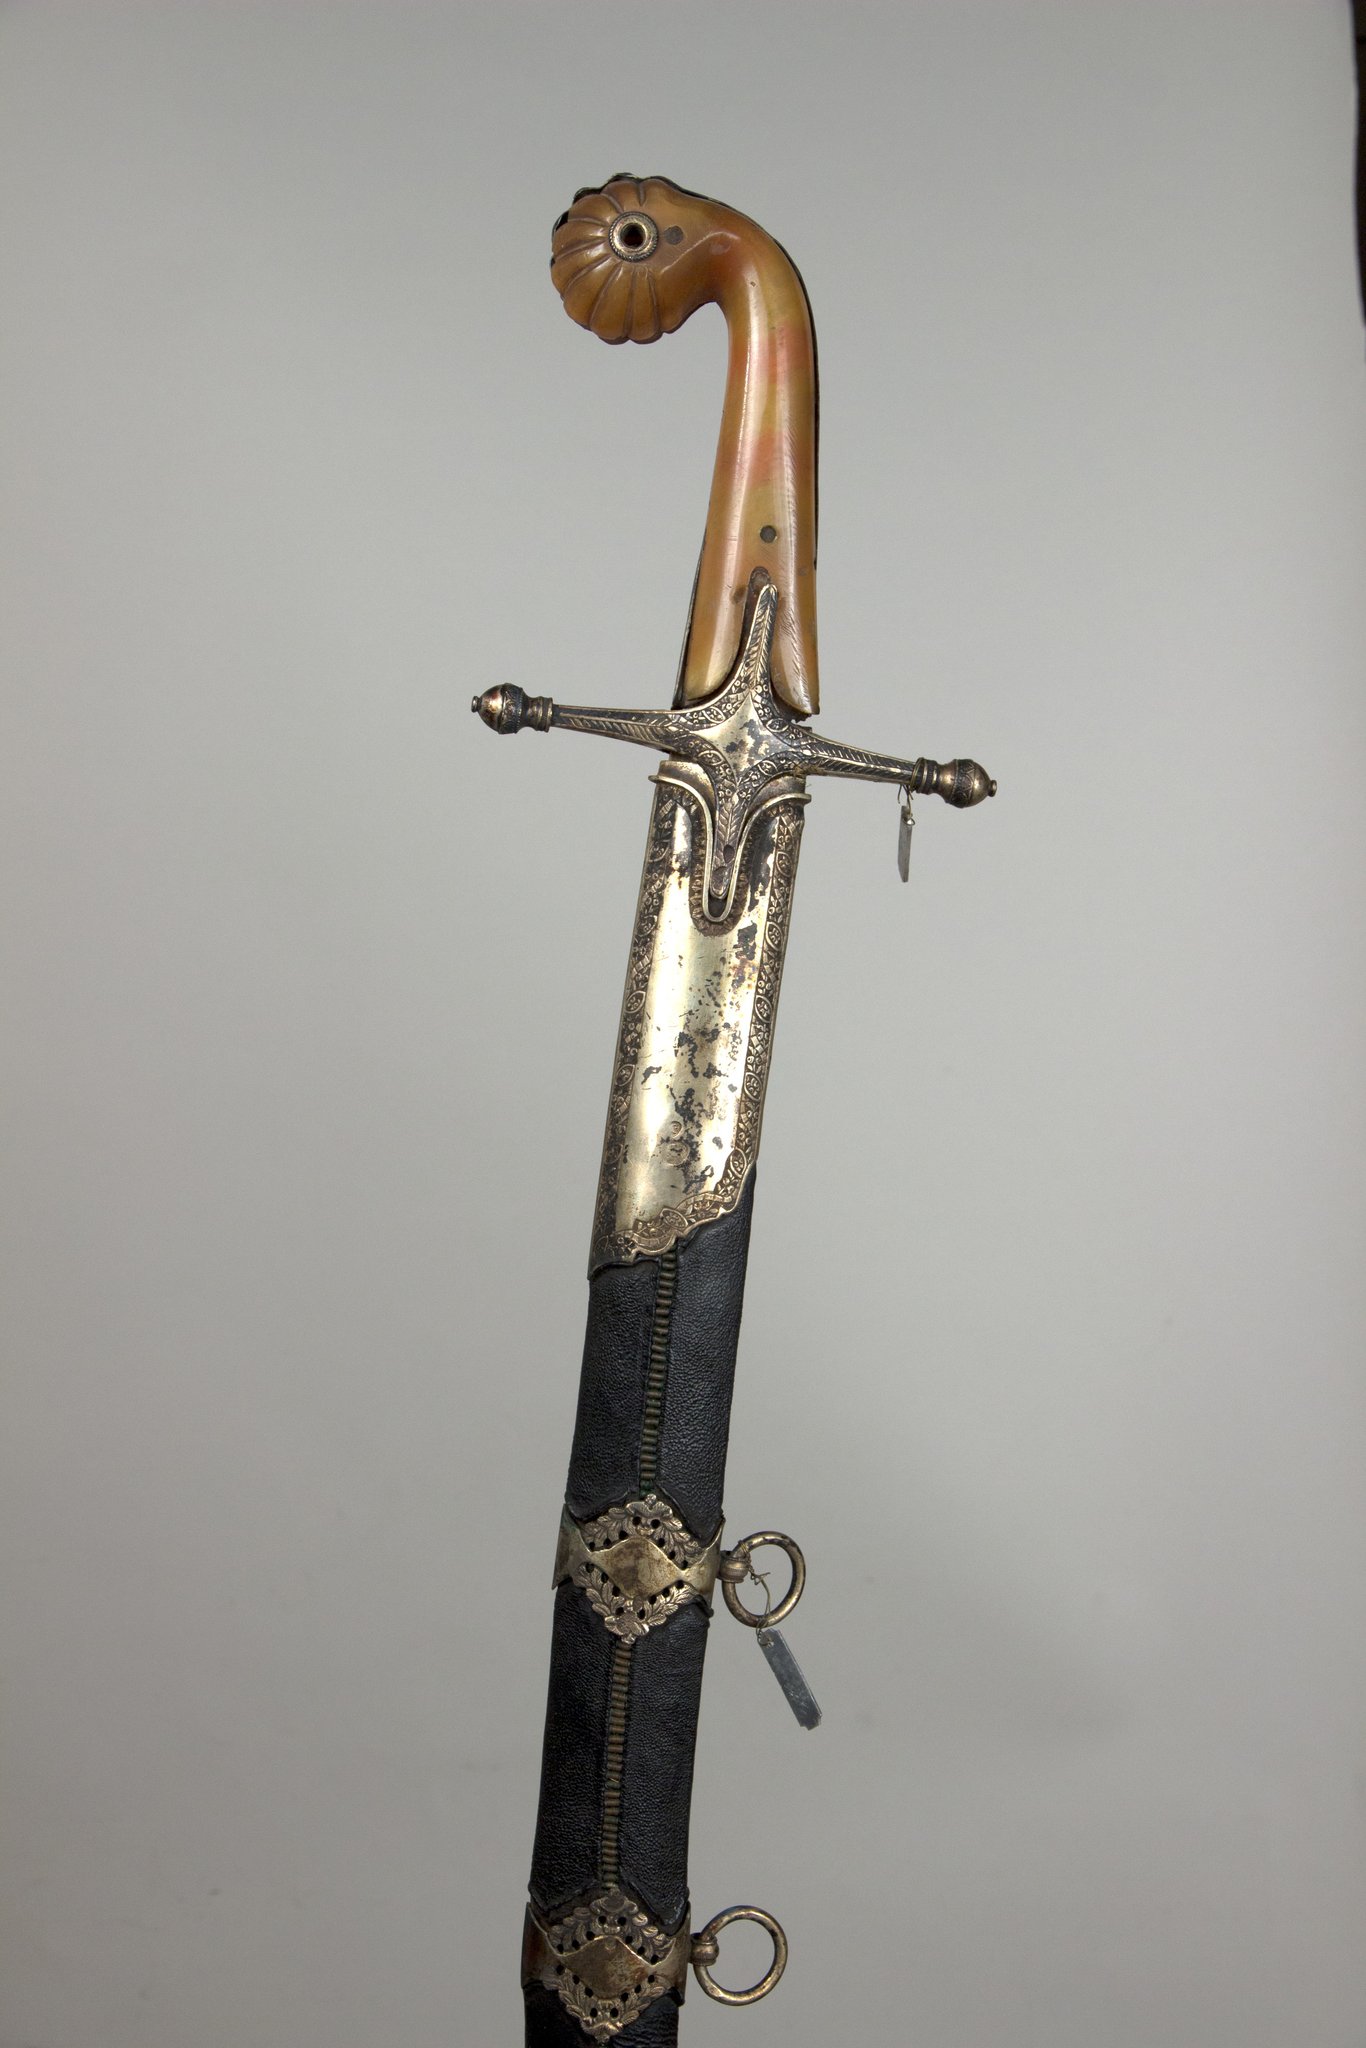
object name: sword with scabbard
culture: arabian or turkish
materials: horn, silver, steel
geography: ottoman empire